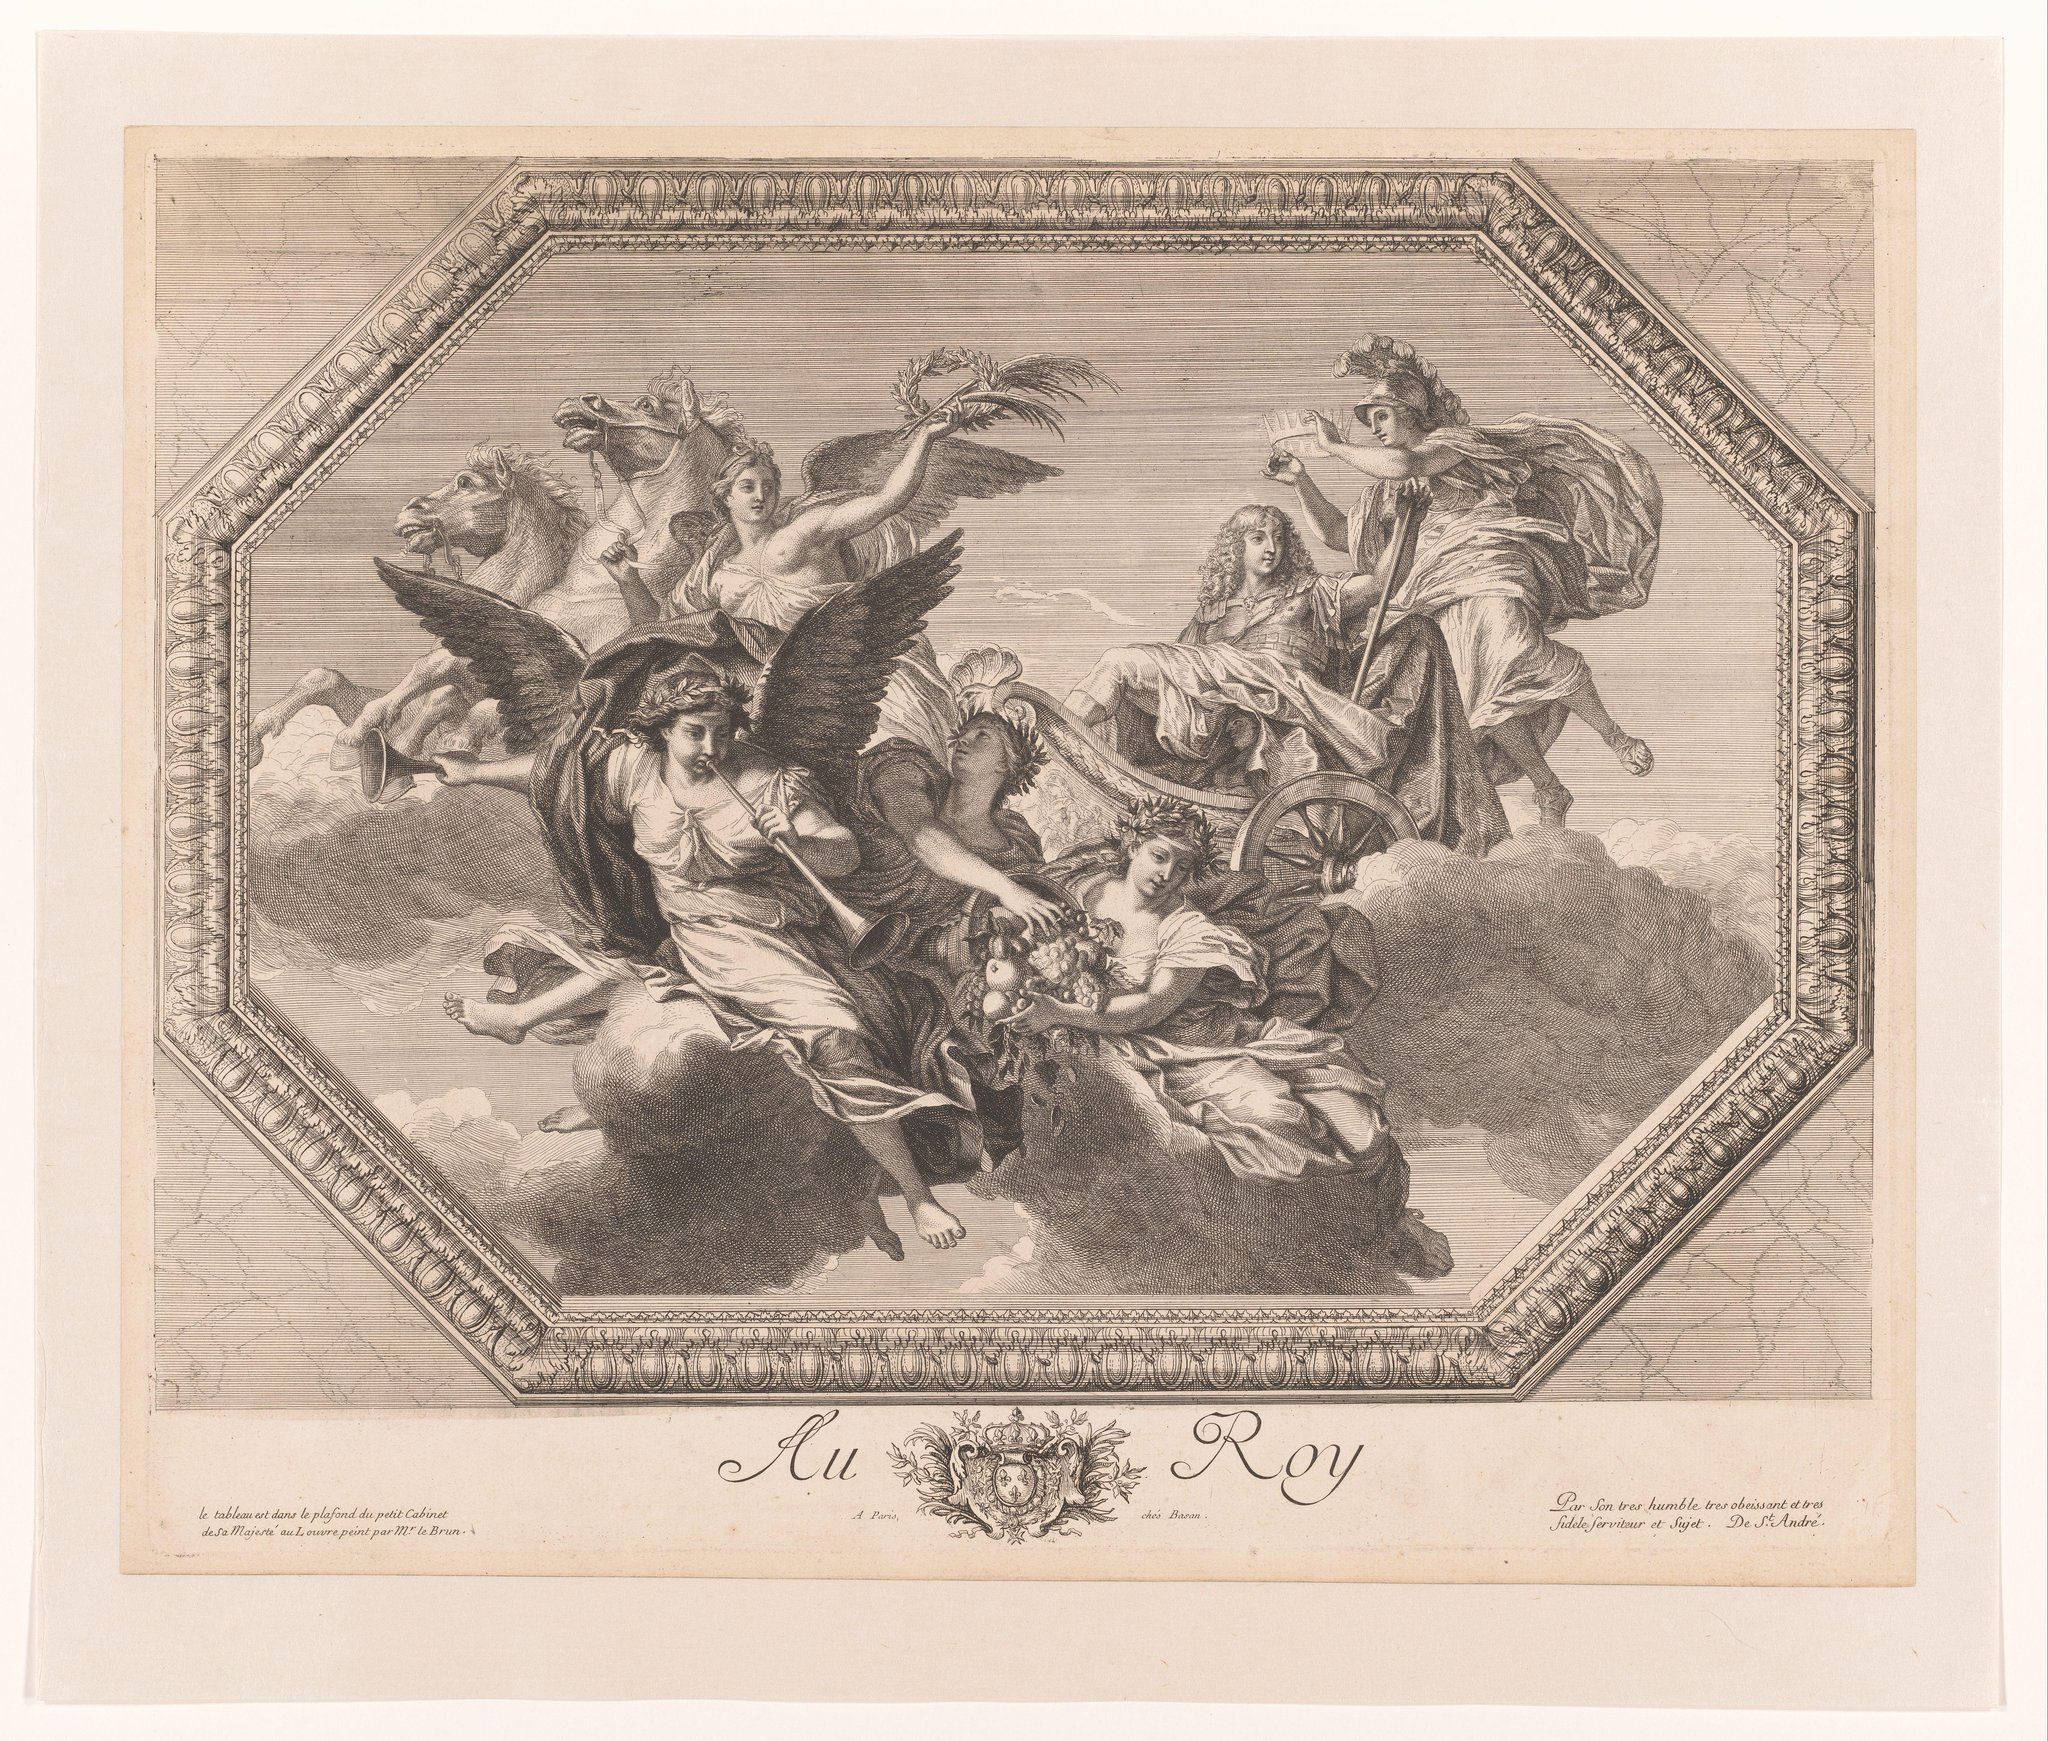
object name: print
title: Galerie van Apollo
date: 1695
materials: paper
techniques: etching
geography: paris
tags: lodewijk xiv (koning van frankrijk), historical persons, emperor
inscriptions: collector's mark: Lugt 2228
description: Allegorie op koning Lodewijk XIV van Frankrijk, weergegeven als een goddelijke figuur uit de klassieke mythologie. Hij rijdt in een praalwagen, die wordt getrokken door twee paarden, over de wolken, omgeven door Fama, Abundantia en twee andere figuren. Minerva houdt een kroon boven zijn hoofd. De voorstelling is gevat in een octogonale ornamentrand. Plafondschildering van Le Brun in de koninklijke zaal in het Louvre.